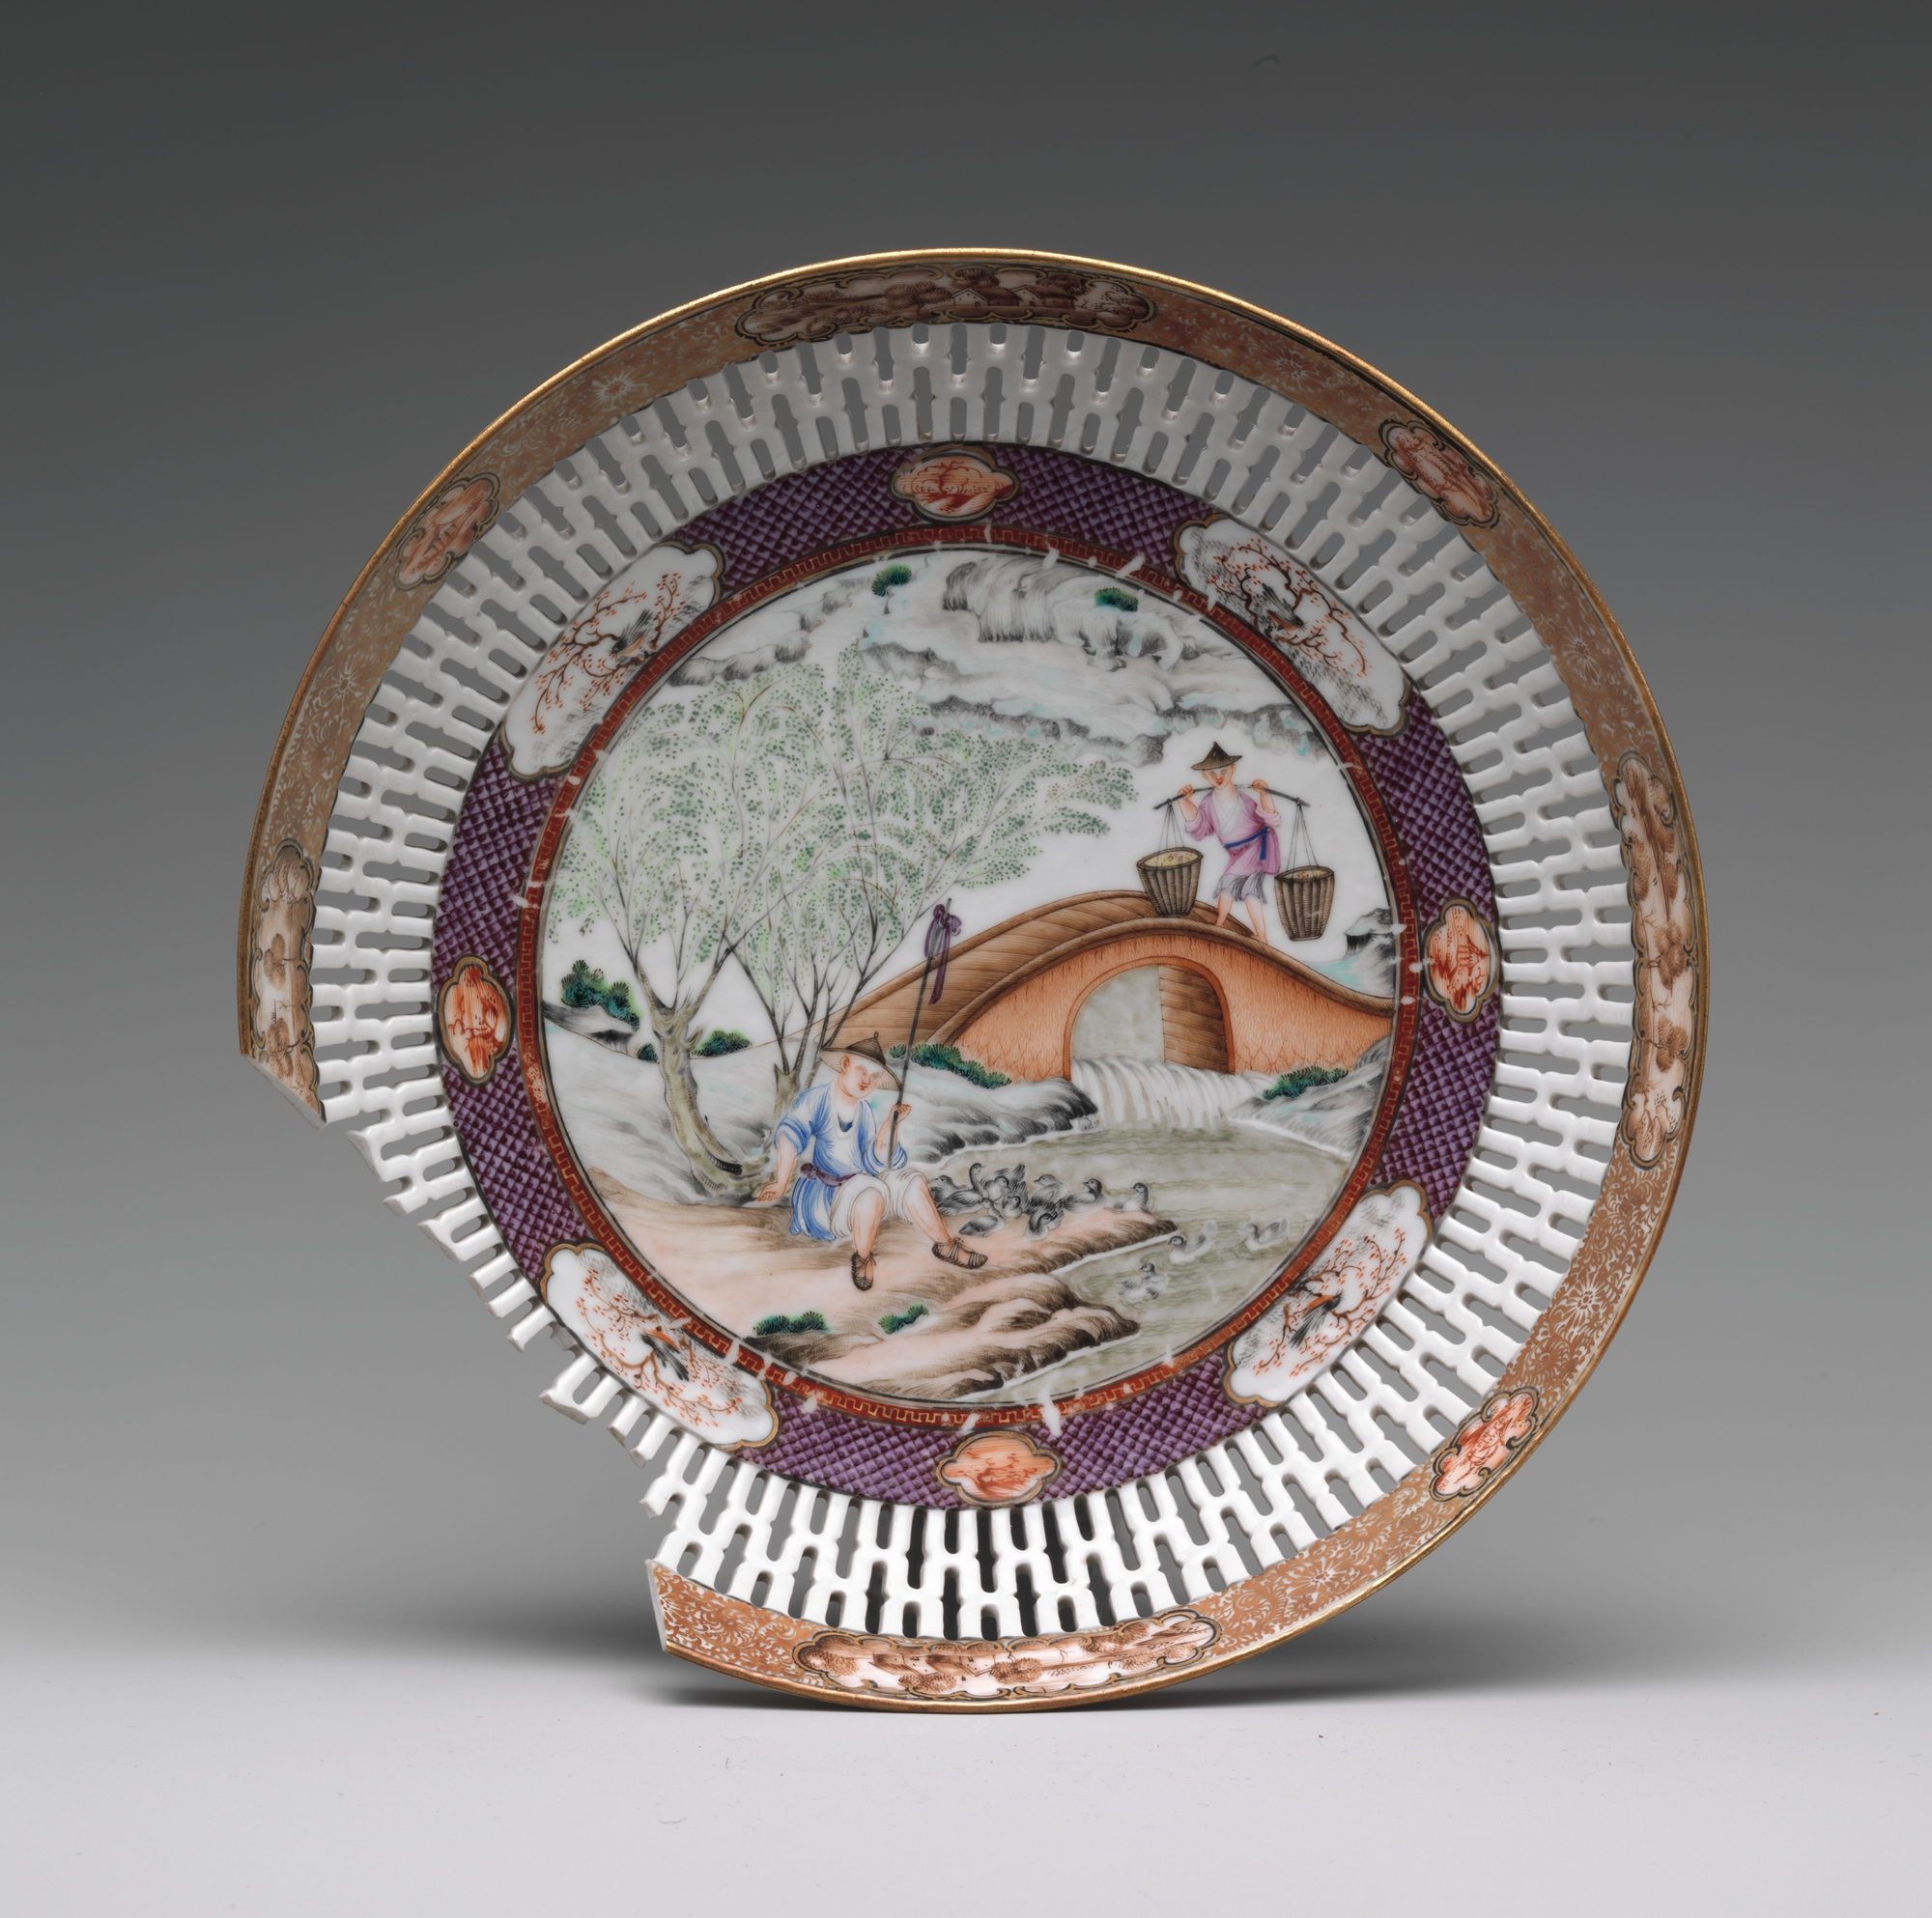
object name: dish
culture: chinese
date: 1736-1795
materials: porcelain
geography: china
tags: bridges,men,trees